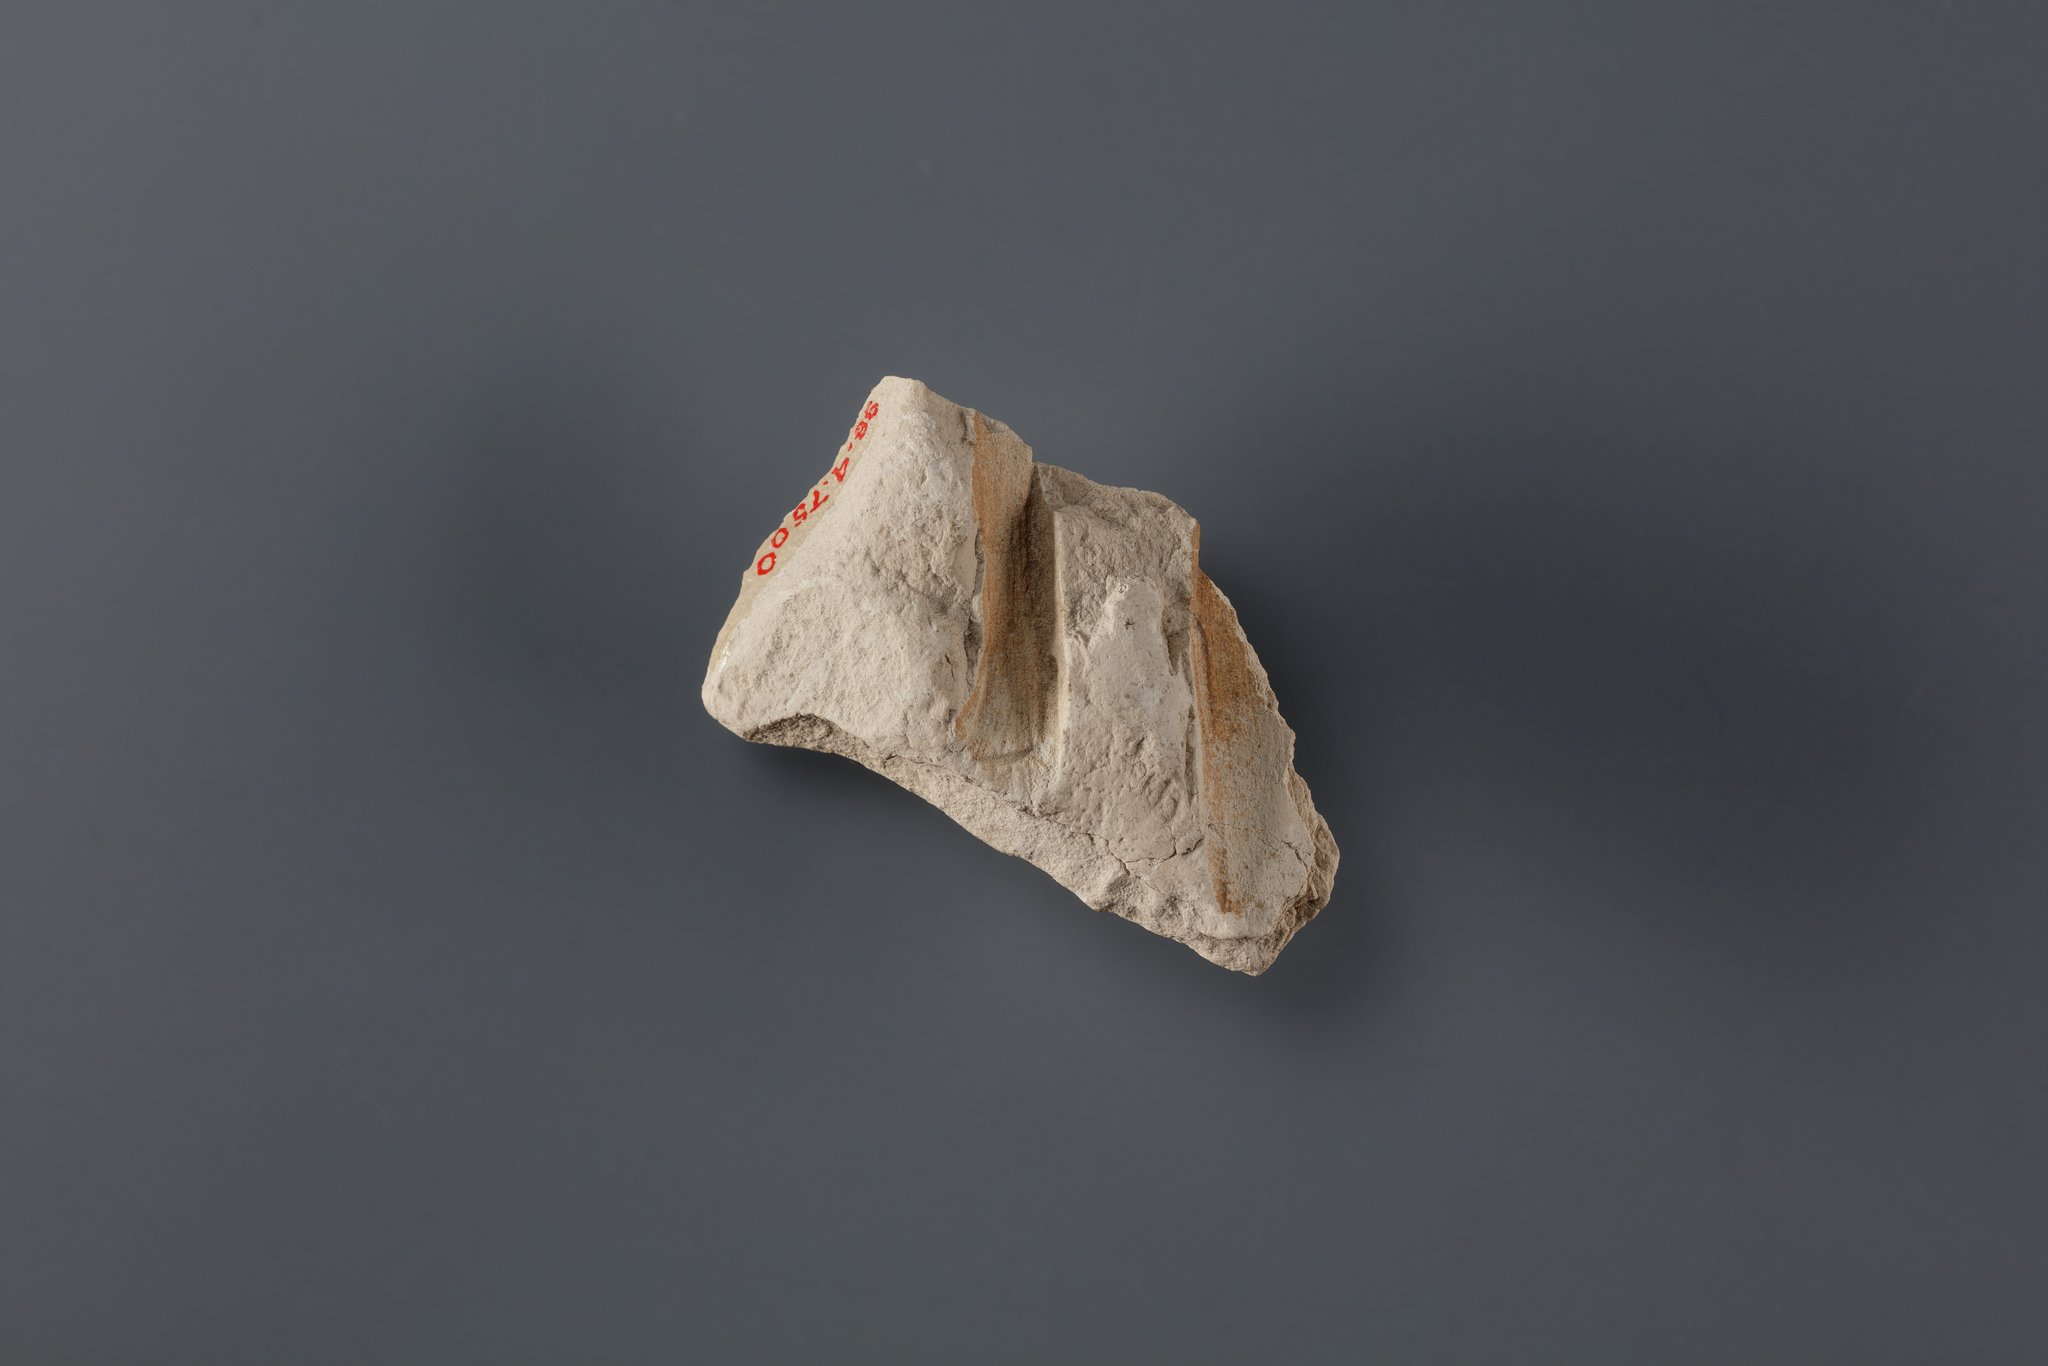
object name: relief fragment 41, tomb of mereri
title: Relief fragment possibly from the tomb of Mereri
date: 2100-2090 BCE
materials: limestone